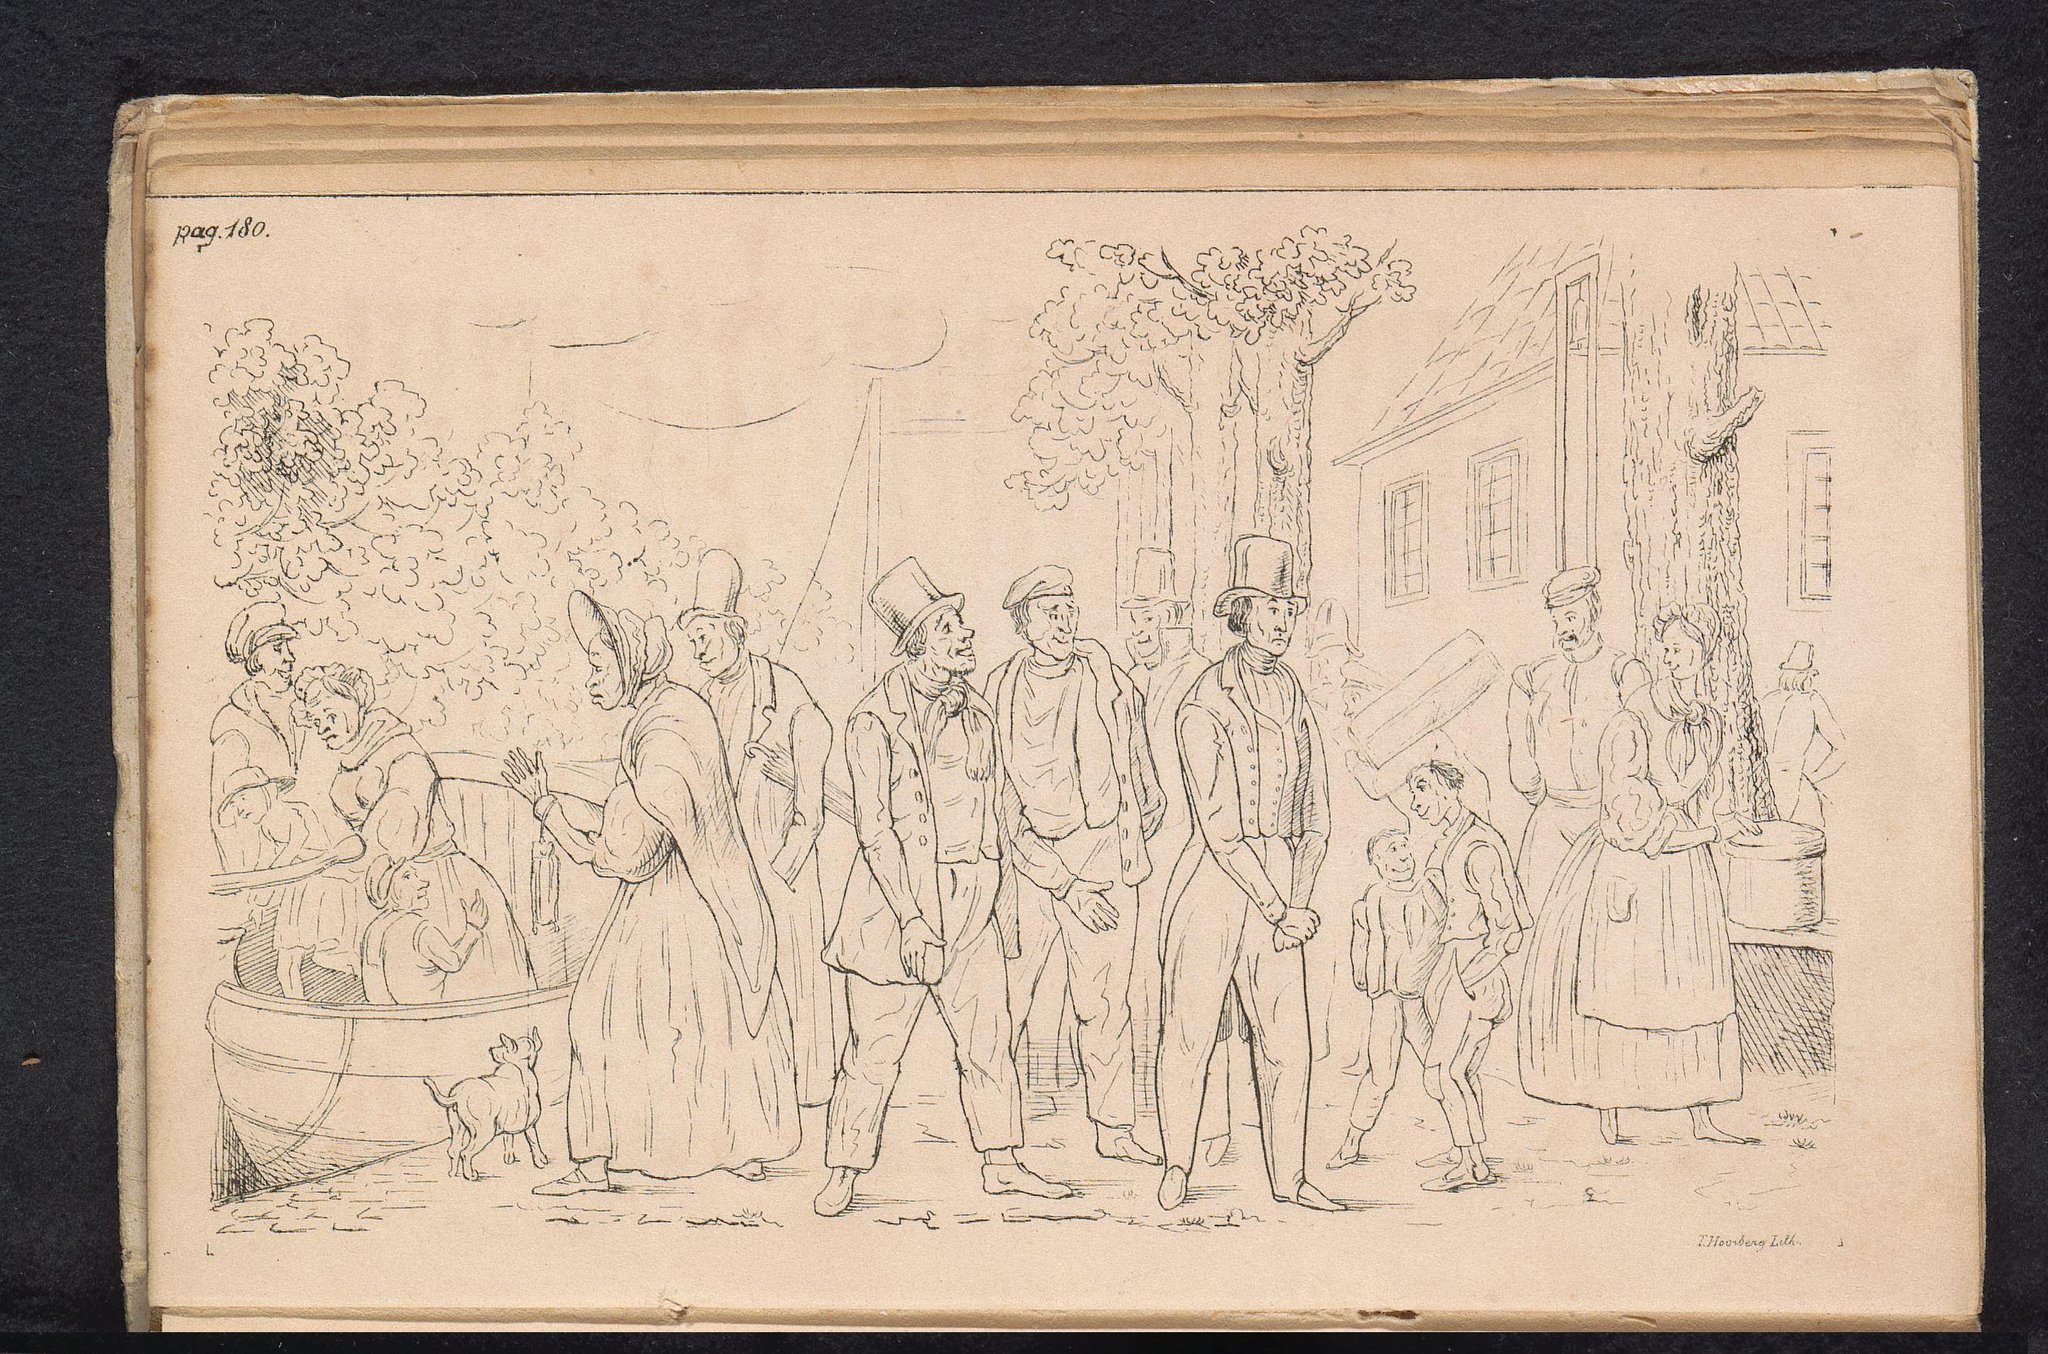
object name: cartoon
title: Blussé lastige inlichtingen vragende over de vertrek- en aankomsttijden van de schuiten, 1841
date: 1841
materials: paper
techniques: lithograph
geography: leiden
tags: student life, leiden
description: De schrijver P. Blussé lastige inlichtingen vragende over de vertrek- en aankomsttijden van de schuiten. Spotprent in de studentenalmanak van de Universiteit van Leiden van het jaar 1841.